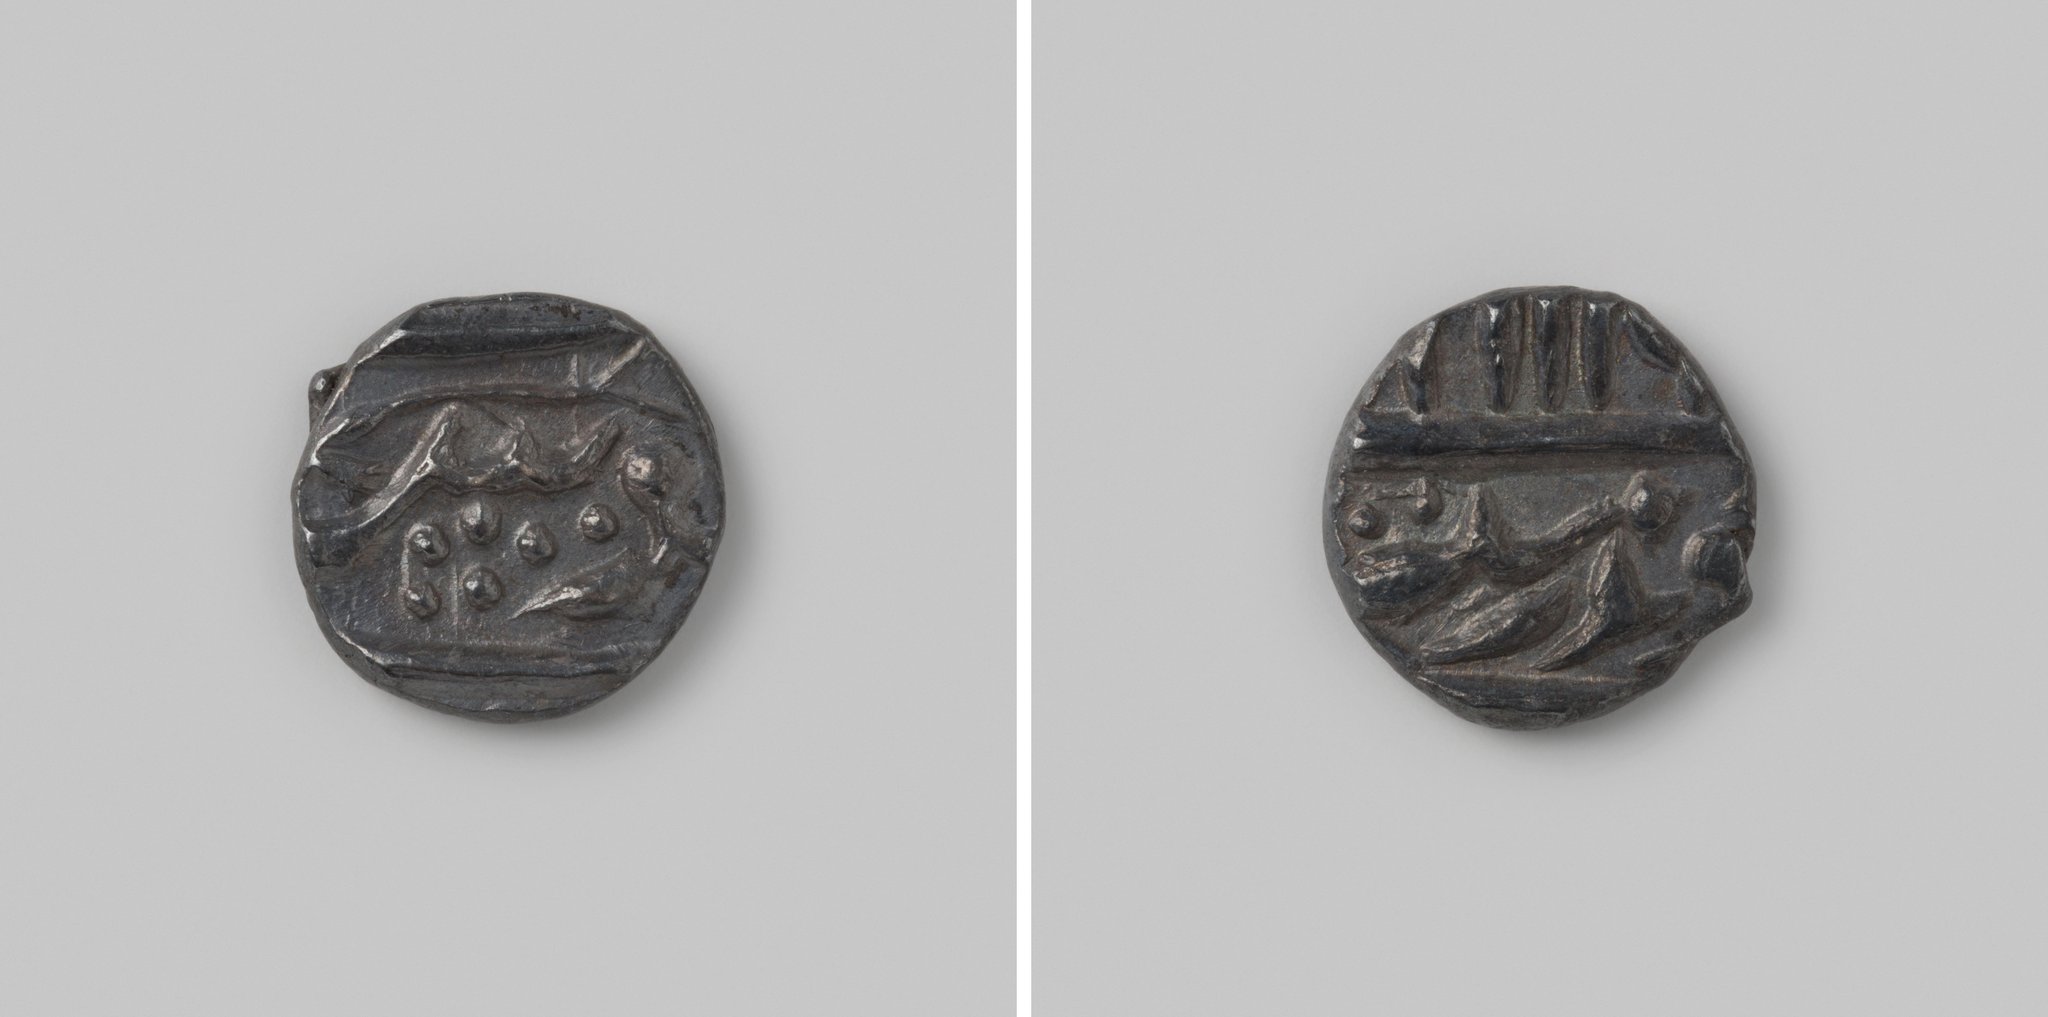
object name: coin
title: 1/16 roepie uit India van sjah Alam II, 1173-1221 [=1759-1806]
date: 1759-1806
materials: silver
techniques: striking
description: Zilveren munt. Voorzijde: in Arabische lettertekens in twee regels opschrift. Keerzijde: in Arabische lettertekens in drie regels opschrift.